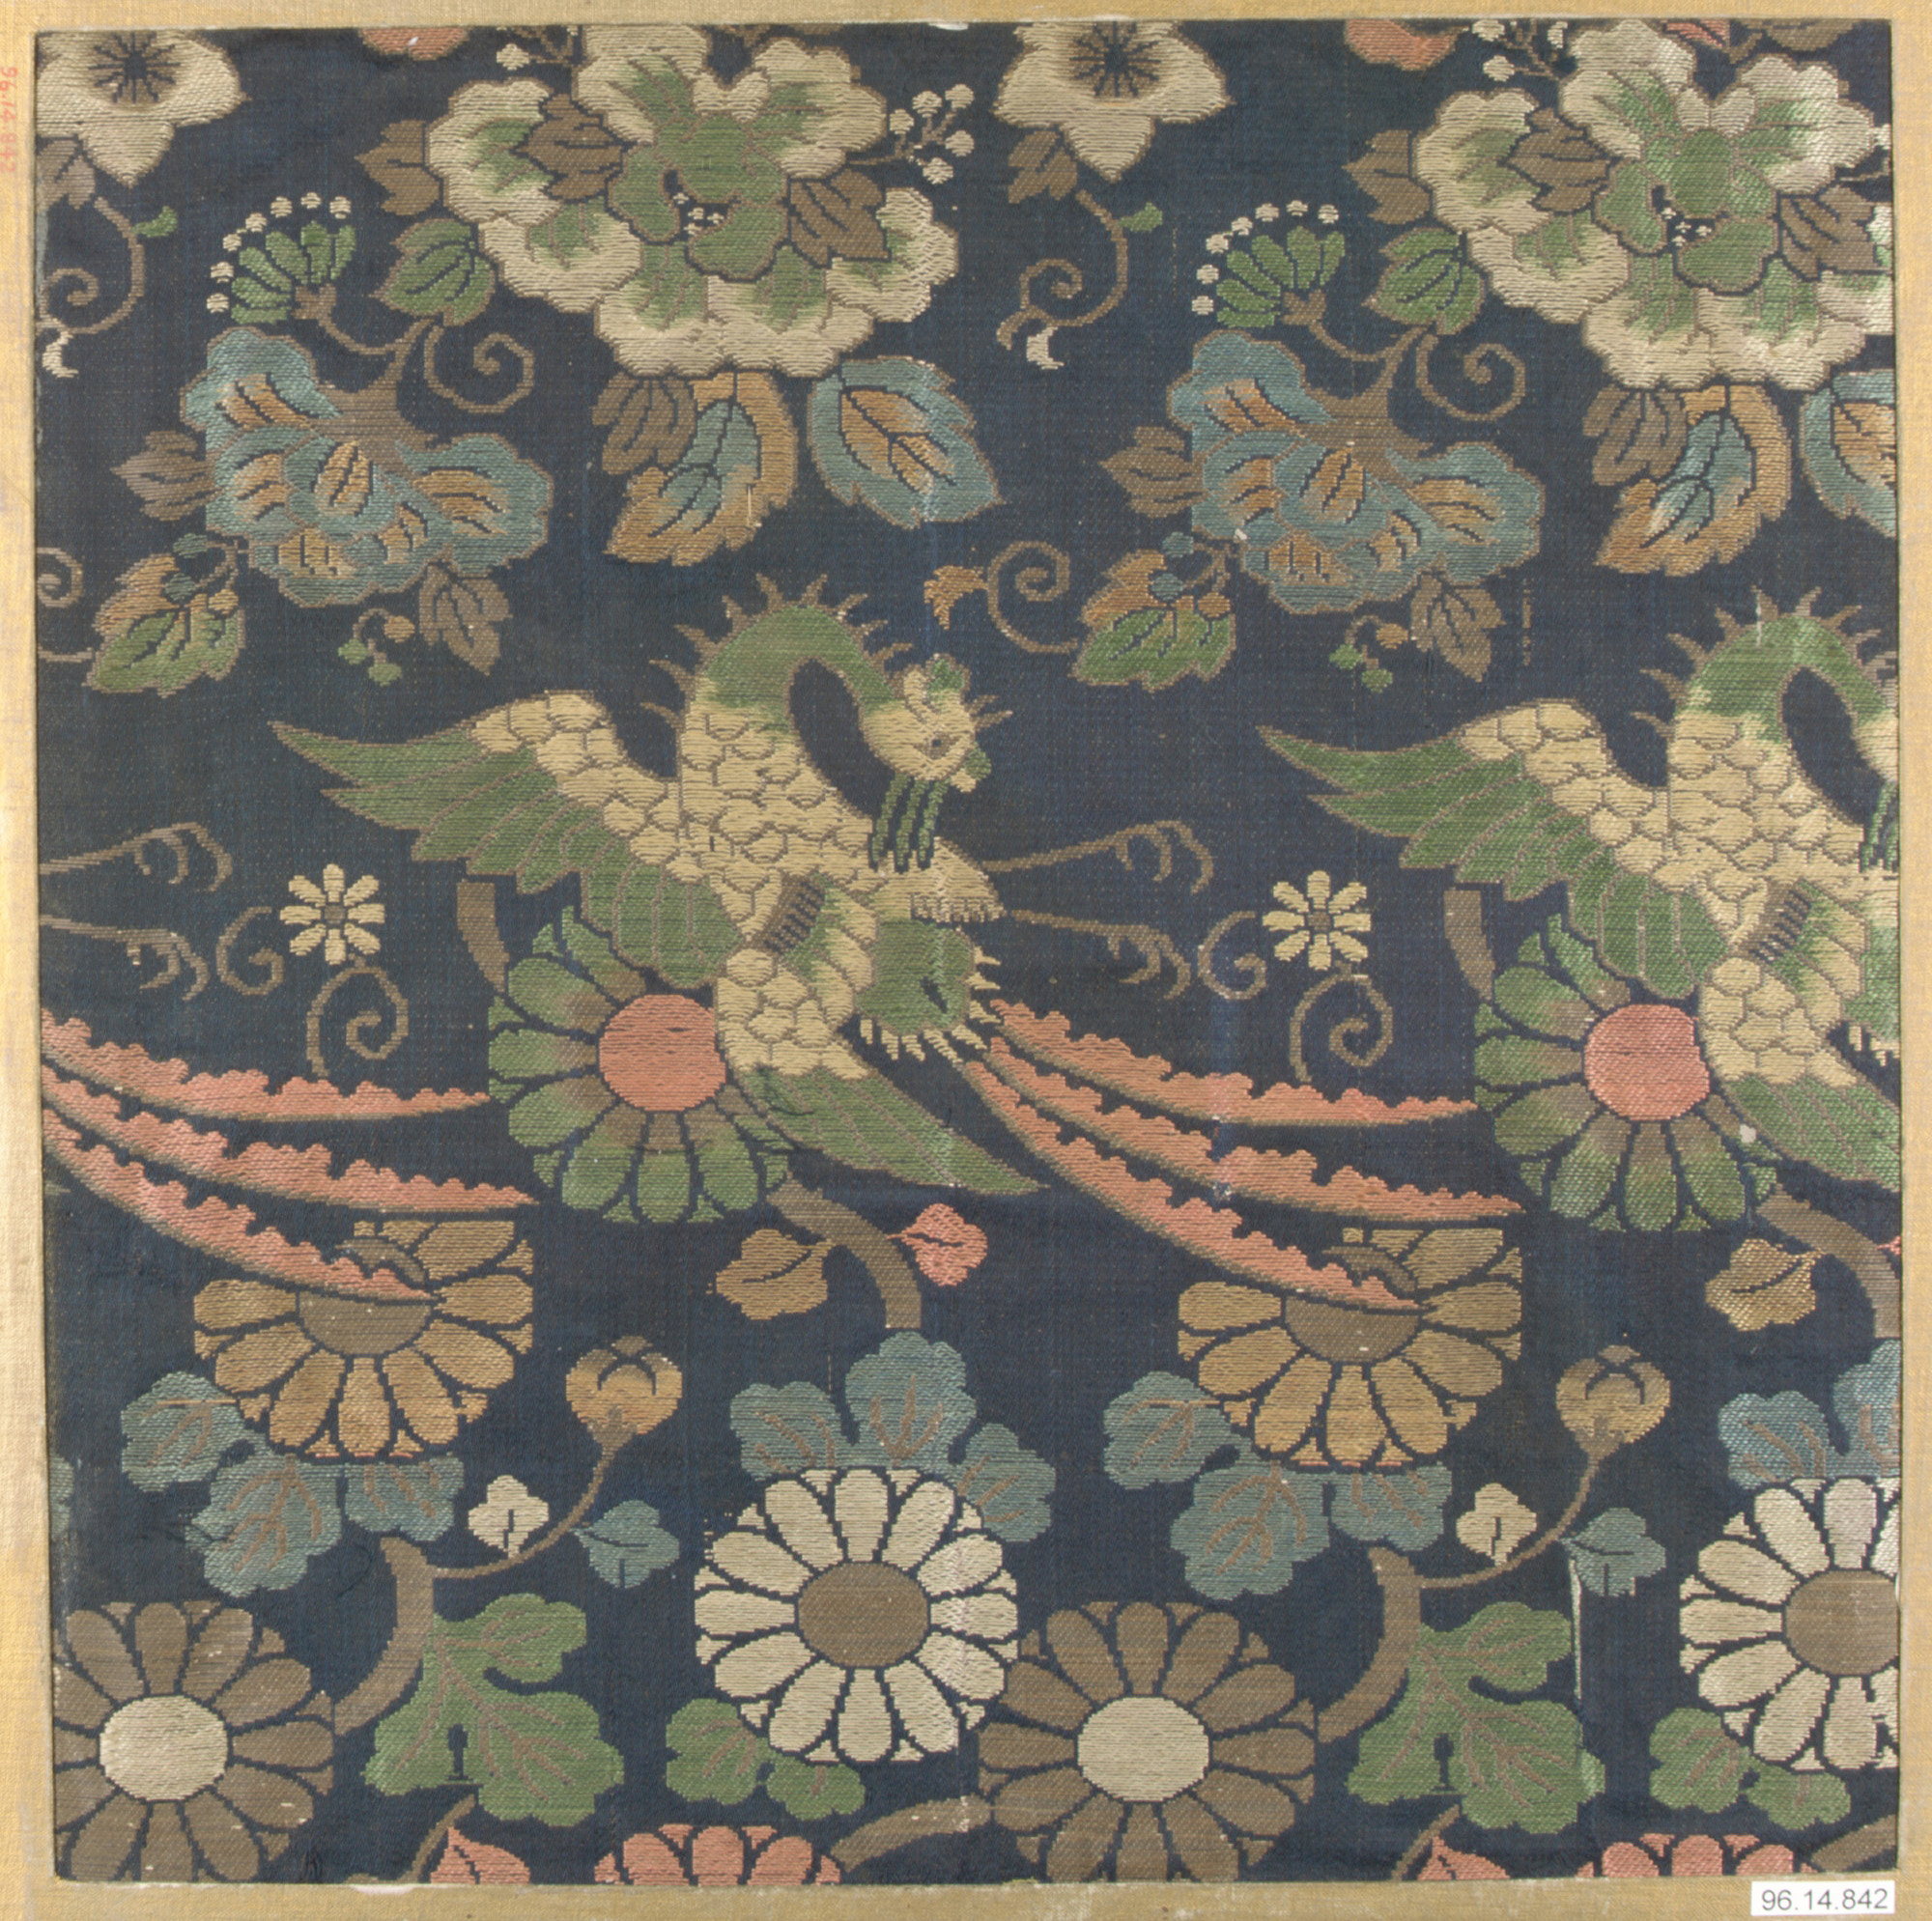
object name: piece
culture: japanese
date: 1701-1900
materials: silk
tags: birds,leaves